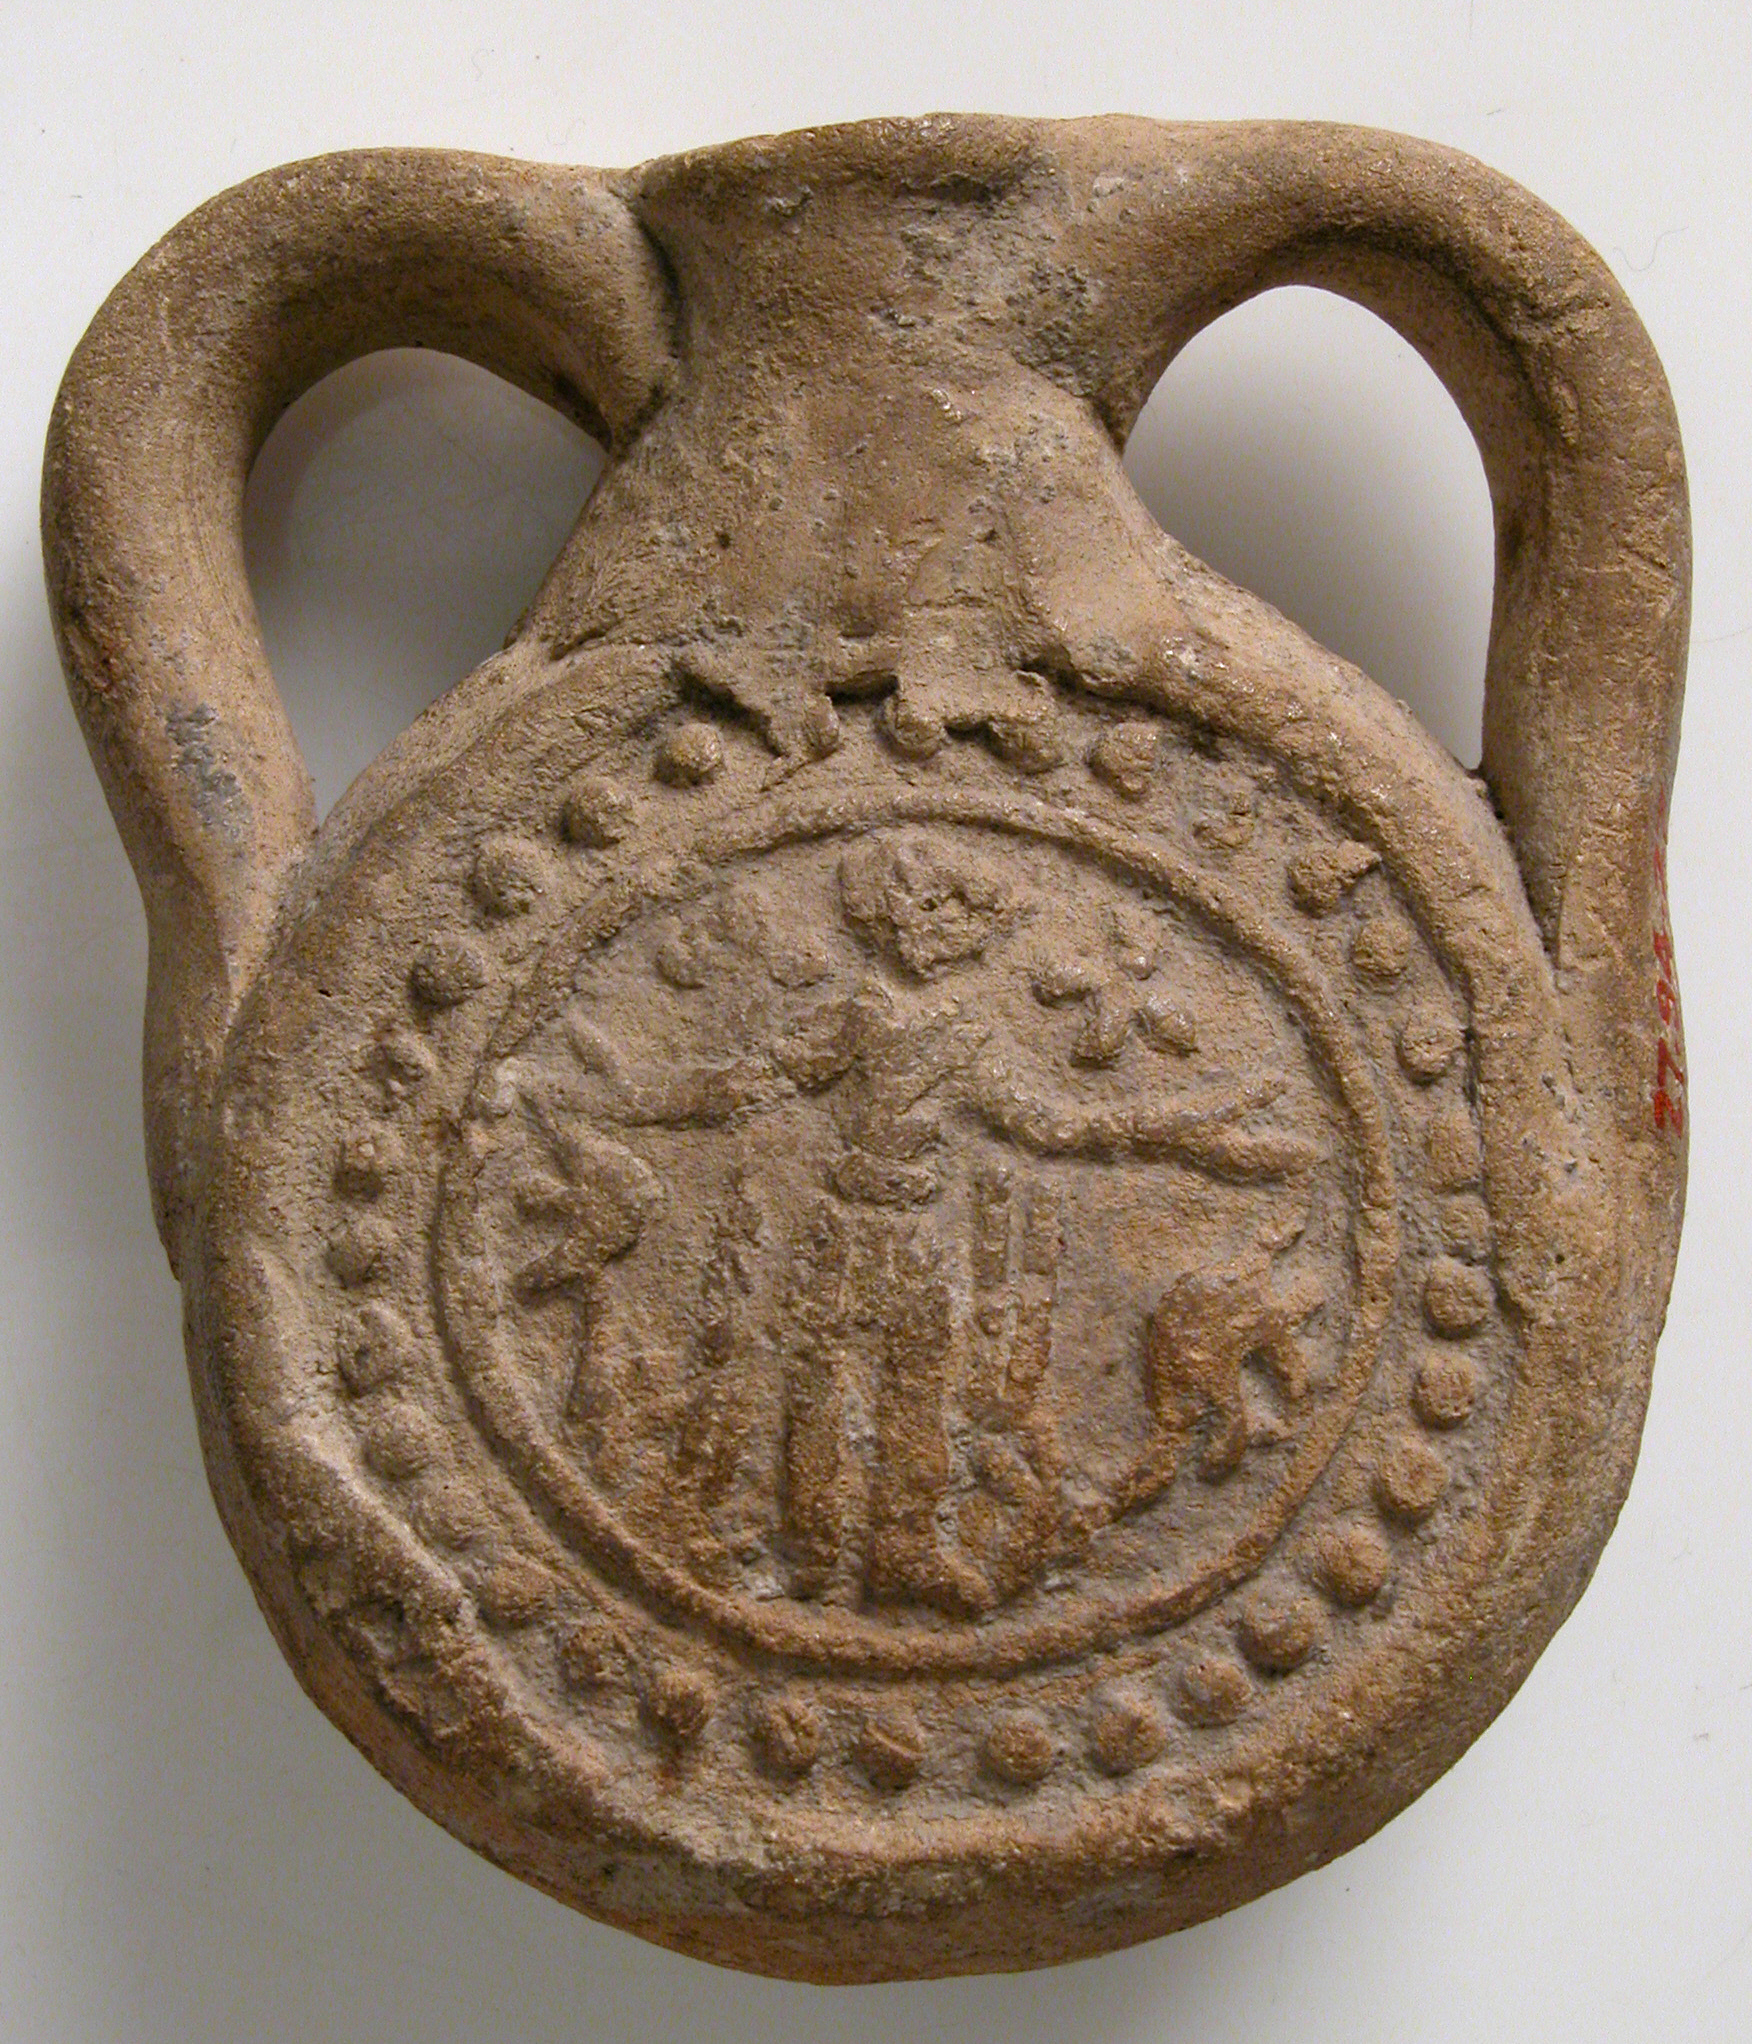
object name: pilgrim flask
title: Ampulla (Flask) of Saint Menas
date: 567-766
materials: earthenware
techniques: molding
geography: egypt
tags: men,saints